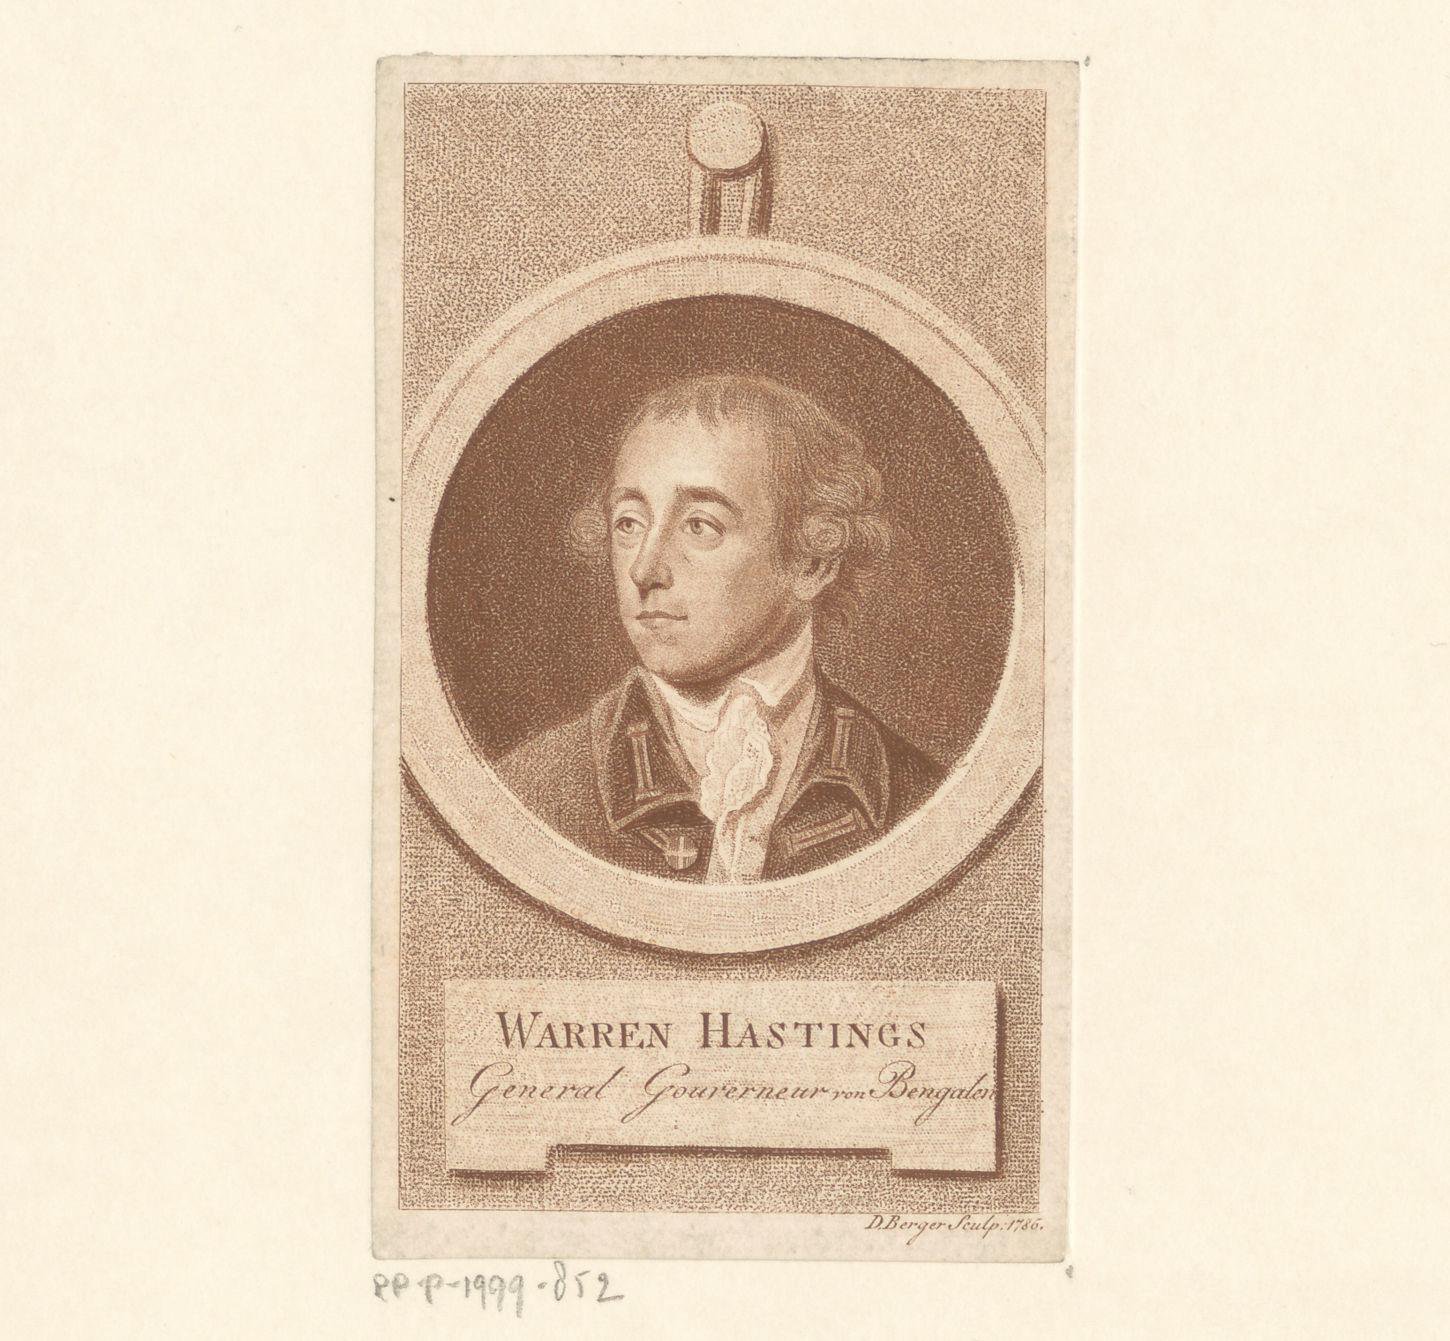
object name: print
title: Portret van Warren Hastings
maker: daniel berger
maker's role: print maker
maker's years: 1744-1824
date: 1786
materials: paper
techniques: etching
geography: berlin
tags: historical persons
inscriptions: collector's mark: Lugt 2760, collector's mark: Lugt 2228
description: Warren Hastings was de eerste gouverneur-generaal van Brits Indië, van 1773 tot 1785.